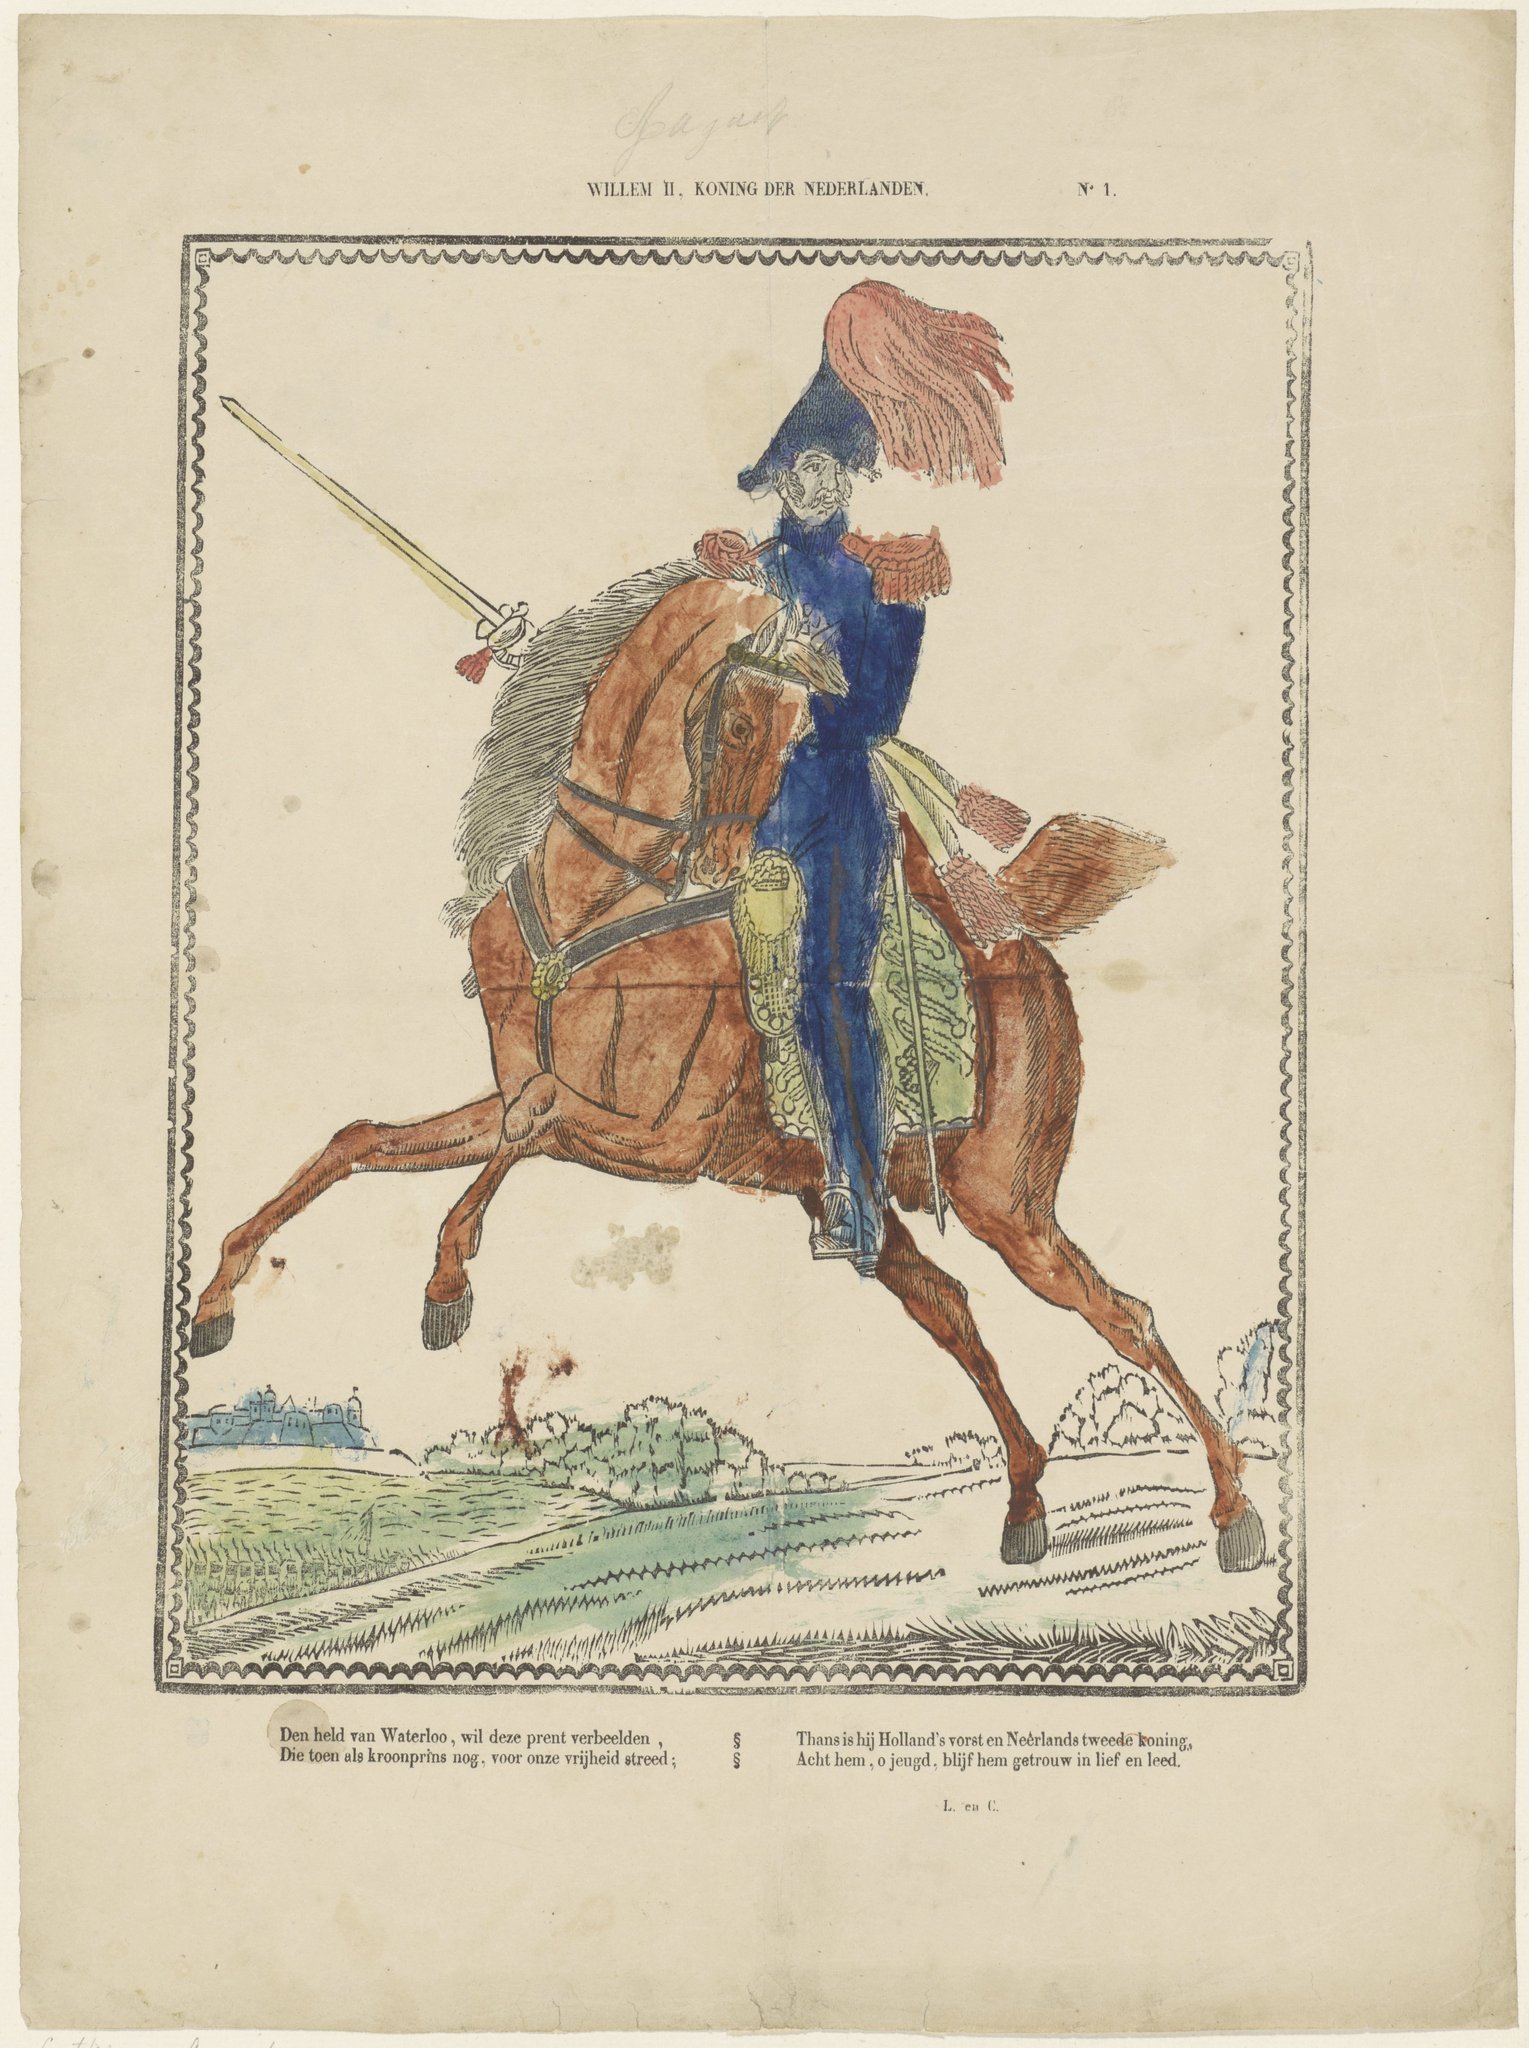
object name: print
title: Willem II, koning der Nederlanden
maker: Anonymous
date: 1848-1881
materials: paper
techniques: colour, letterpress printing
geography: den bosch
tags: the hague, william ii of the netherlands, equestrian state-portrait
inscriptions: collector's mark: Lugt 2760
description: Ruiterportret van koning Willem II, omgeven door een lijst. Onder de afbeelding een vierregelig vers in twee kolommen. Genummerd rechtsboven: No. 1.